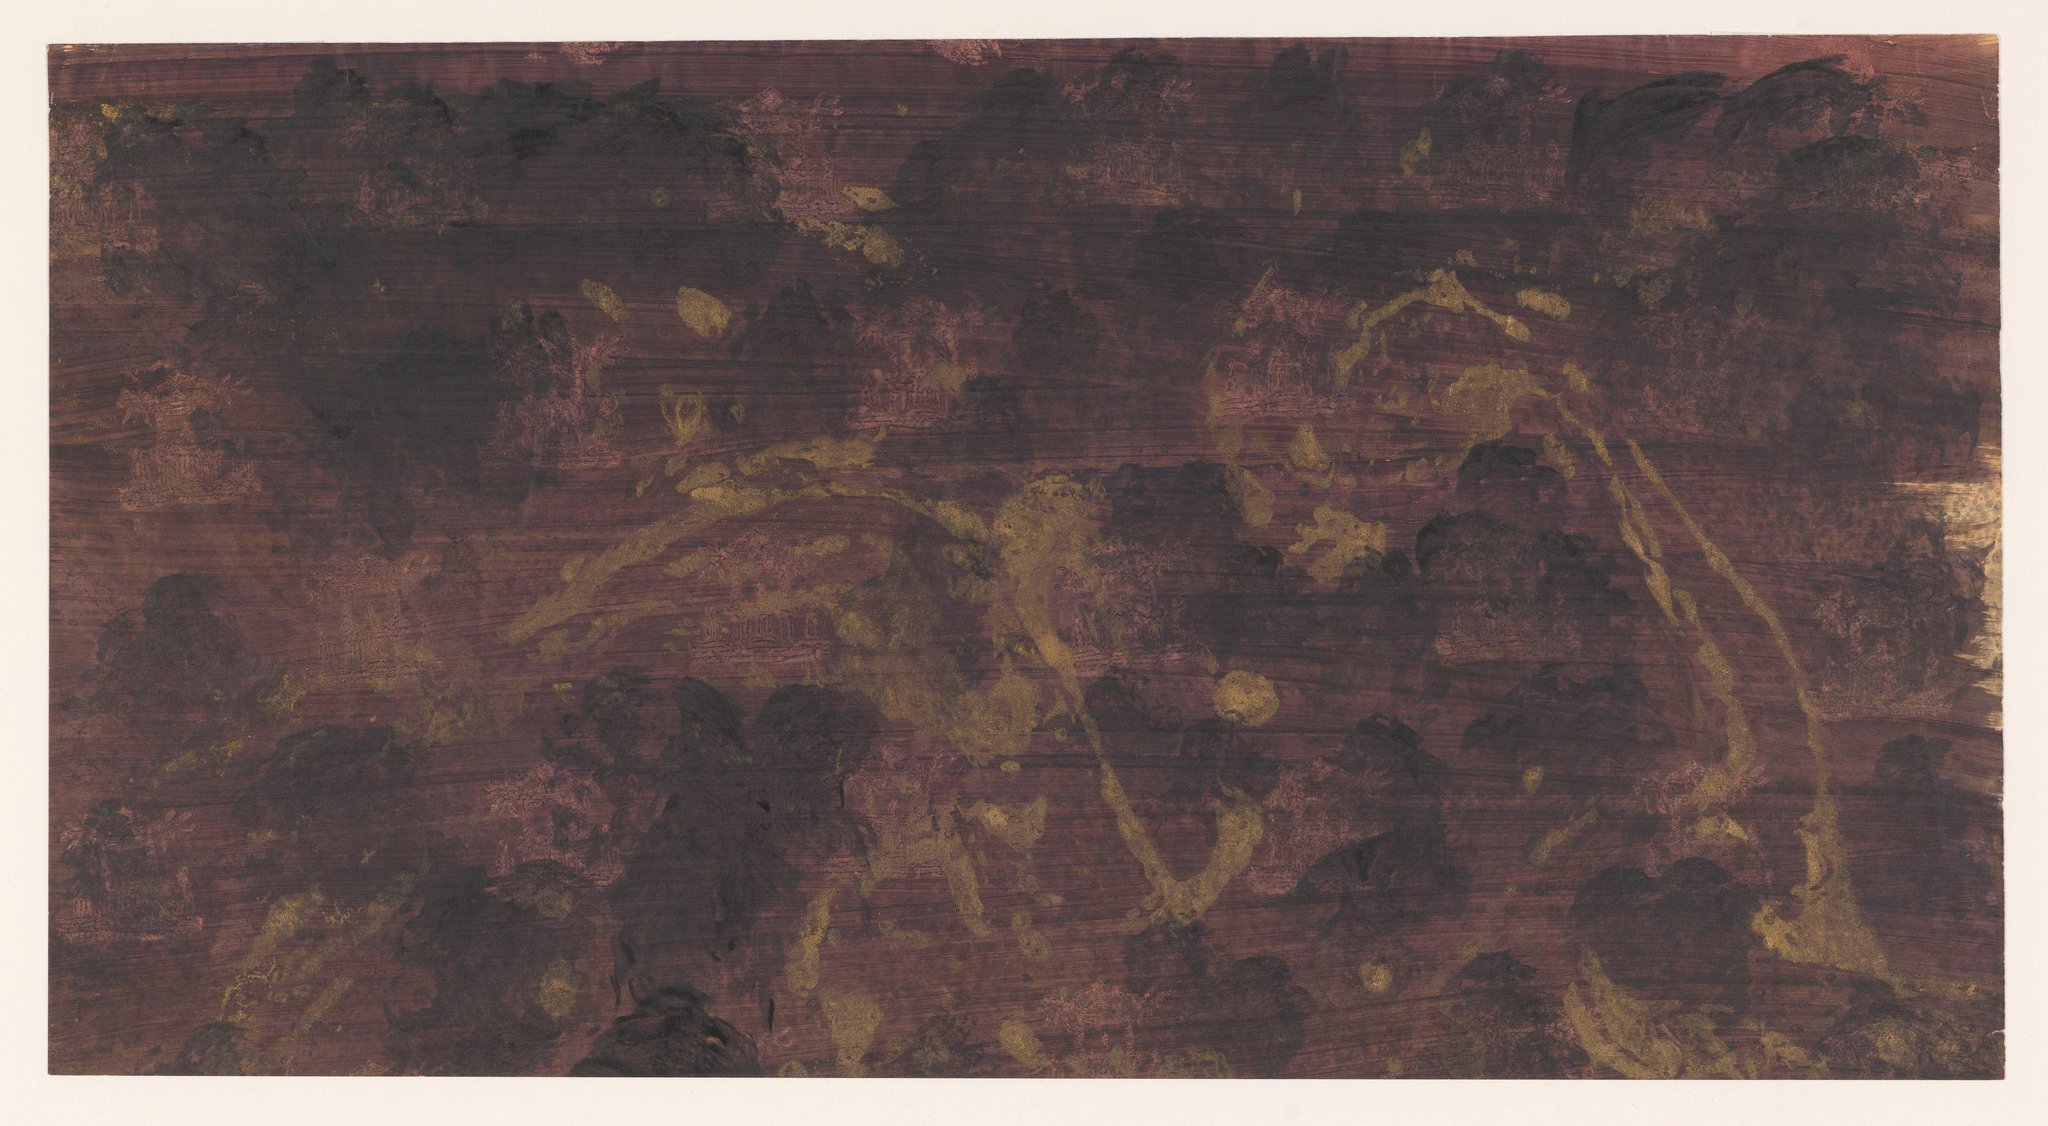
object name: paste paper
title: Gestreken stijfselverfpapier in paars, zwart en goud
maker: Anonymous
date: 1900-1969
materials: paint, paper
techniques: starch dyeing, stamping